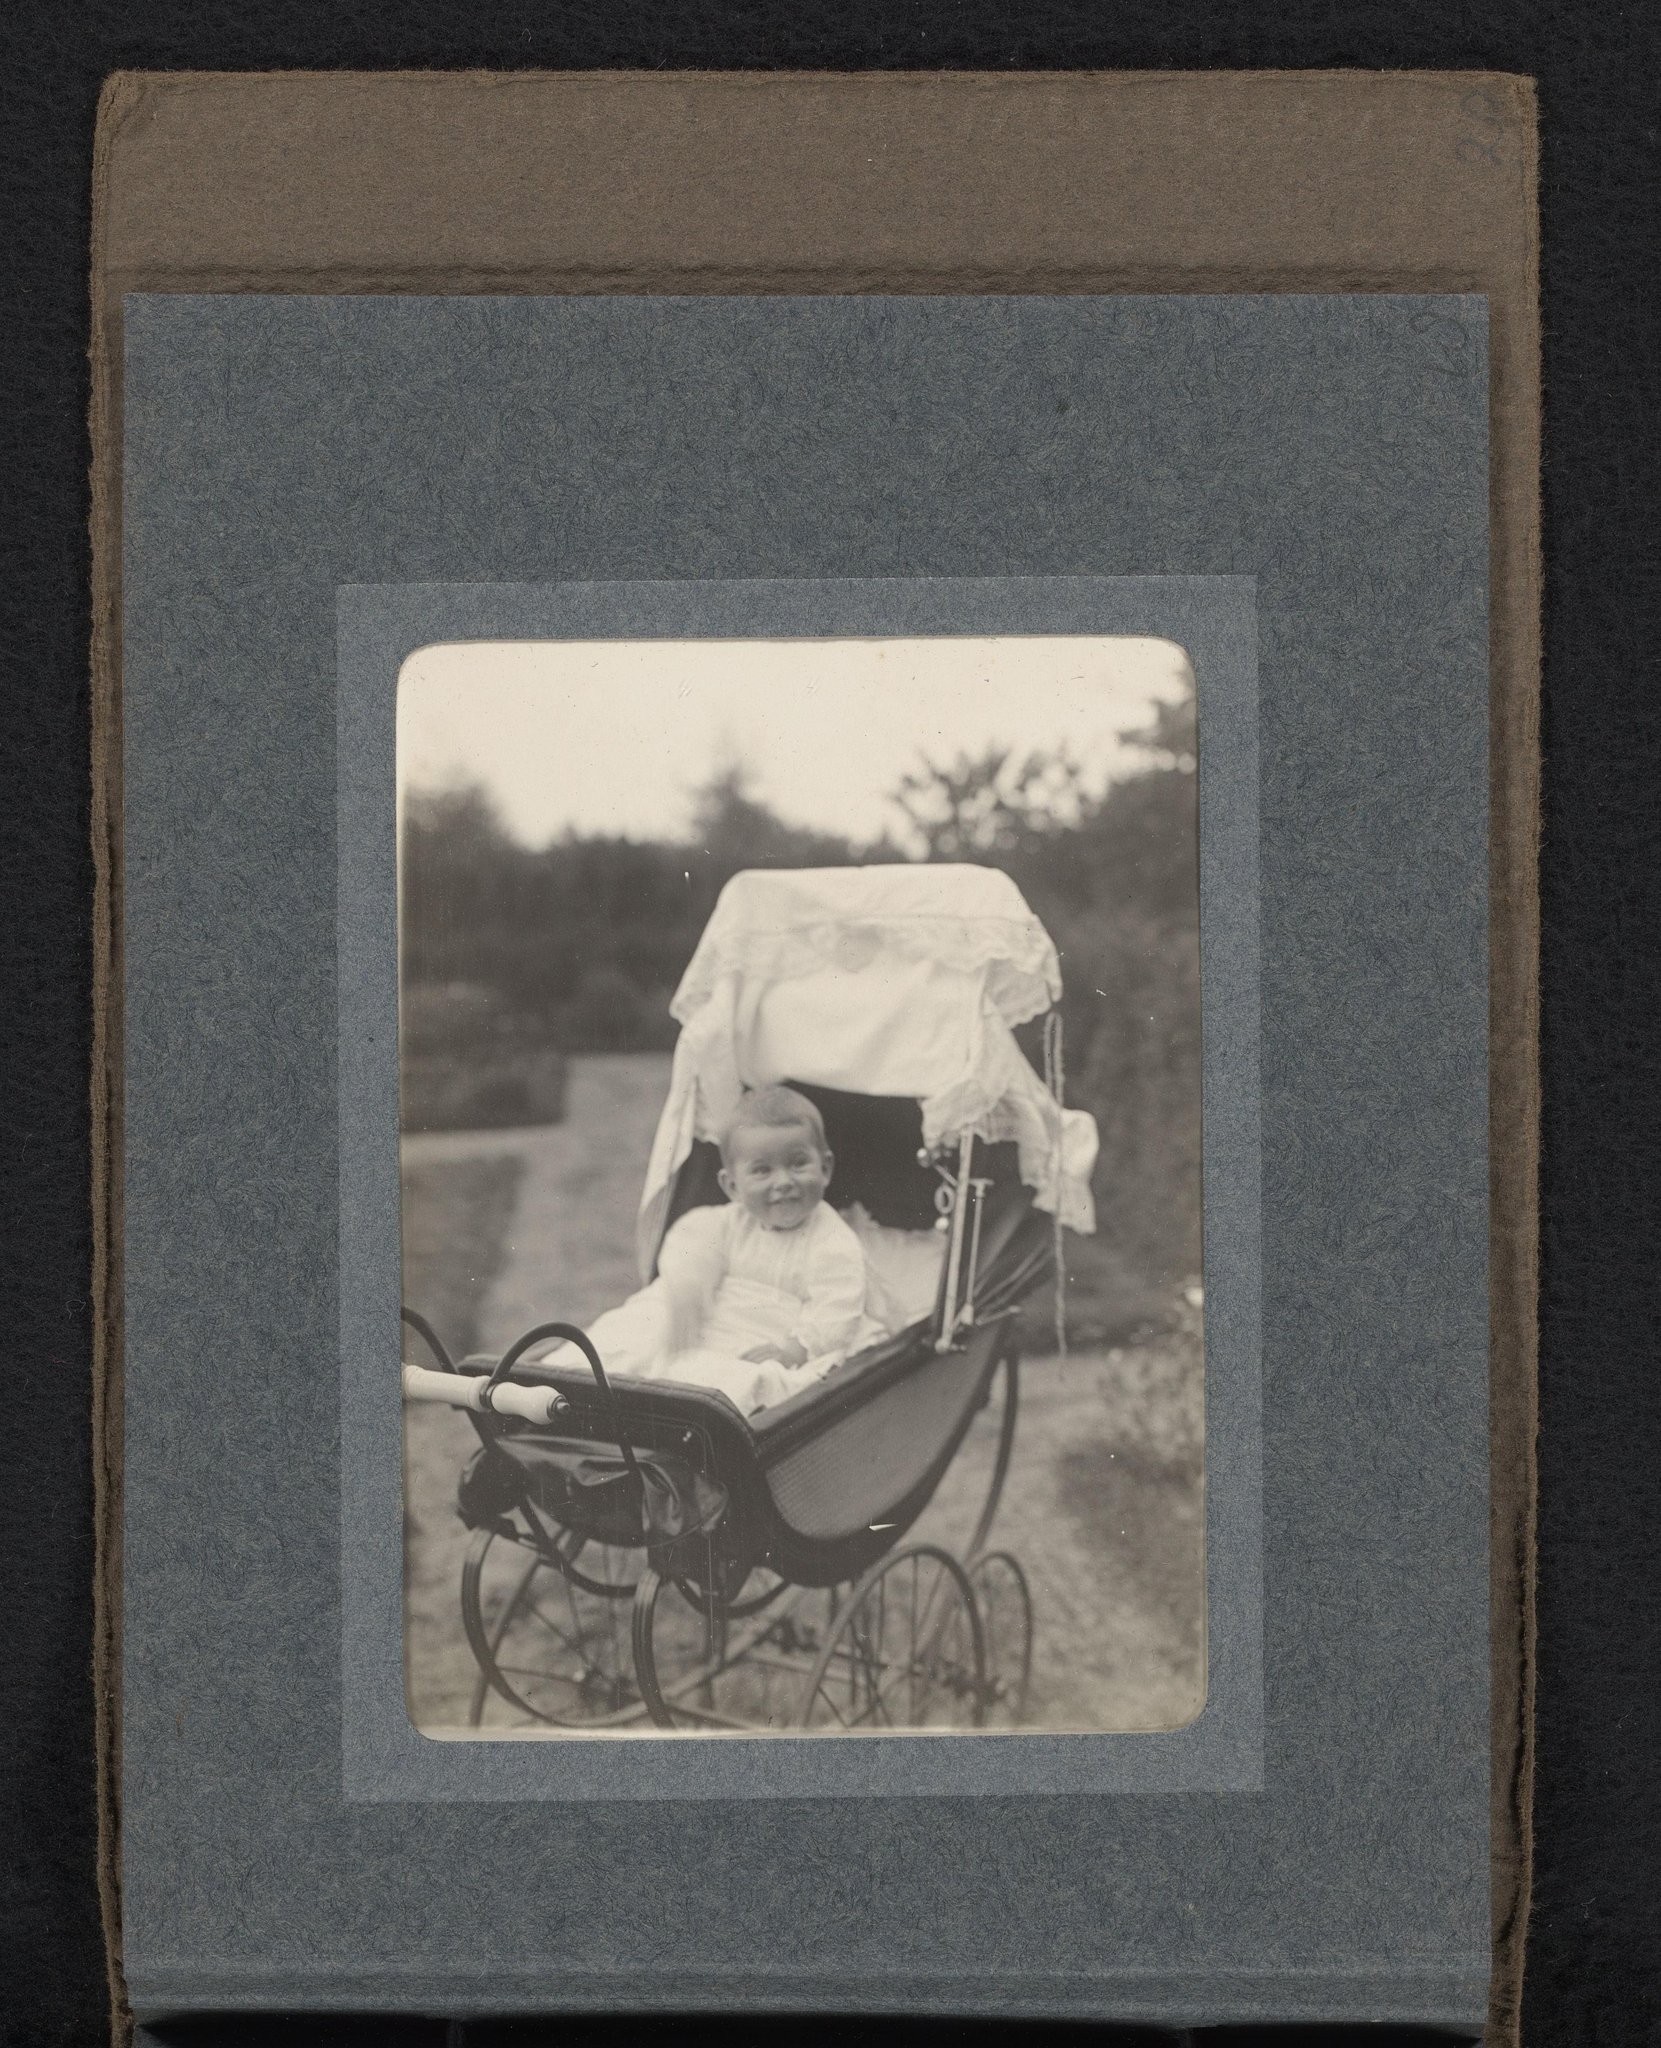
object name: photograph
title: Frank van den Berg in een wandelwagen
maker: hendrik herman van den berg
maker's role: amateurfotograaf, jurist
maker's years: 1875-1944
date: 1913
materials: paper, cardboard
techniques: gelatin silver print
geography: blaricum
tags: frank willem van den berg (1912-1998), baby-carriage, pram, perambulator, historical persons, infant, baby